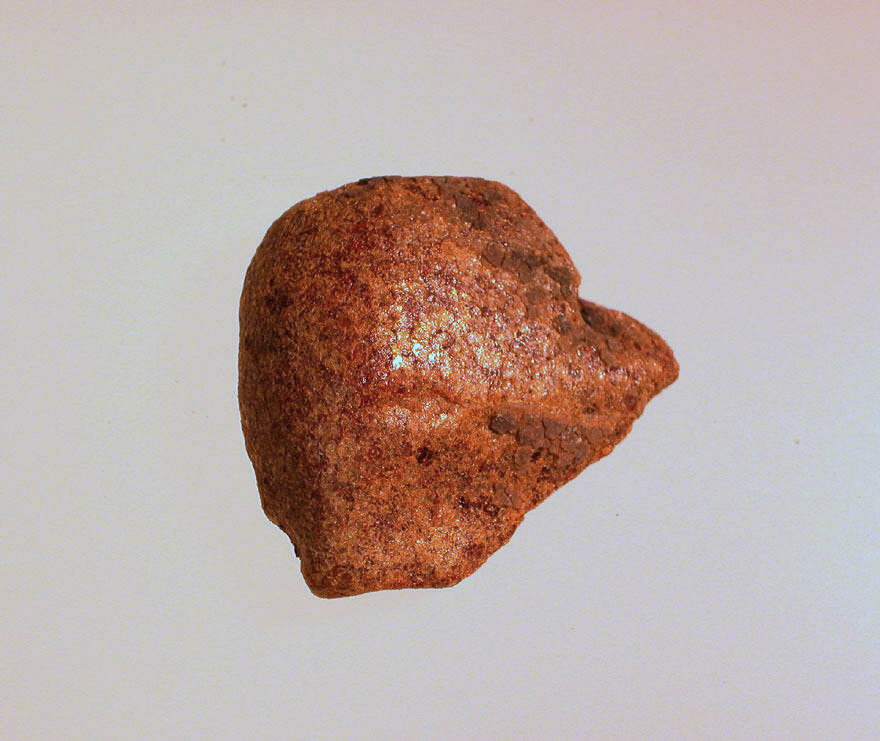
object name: head of a woman to left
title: Pendant: head of a woman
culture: italic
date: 500-401 BCE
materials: amber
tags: heads